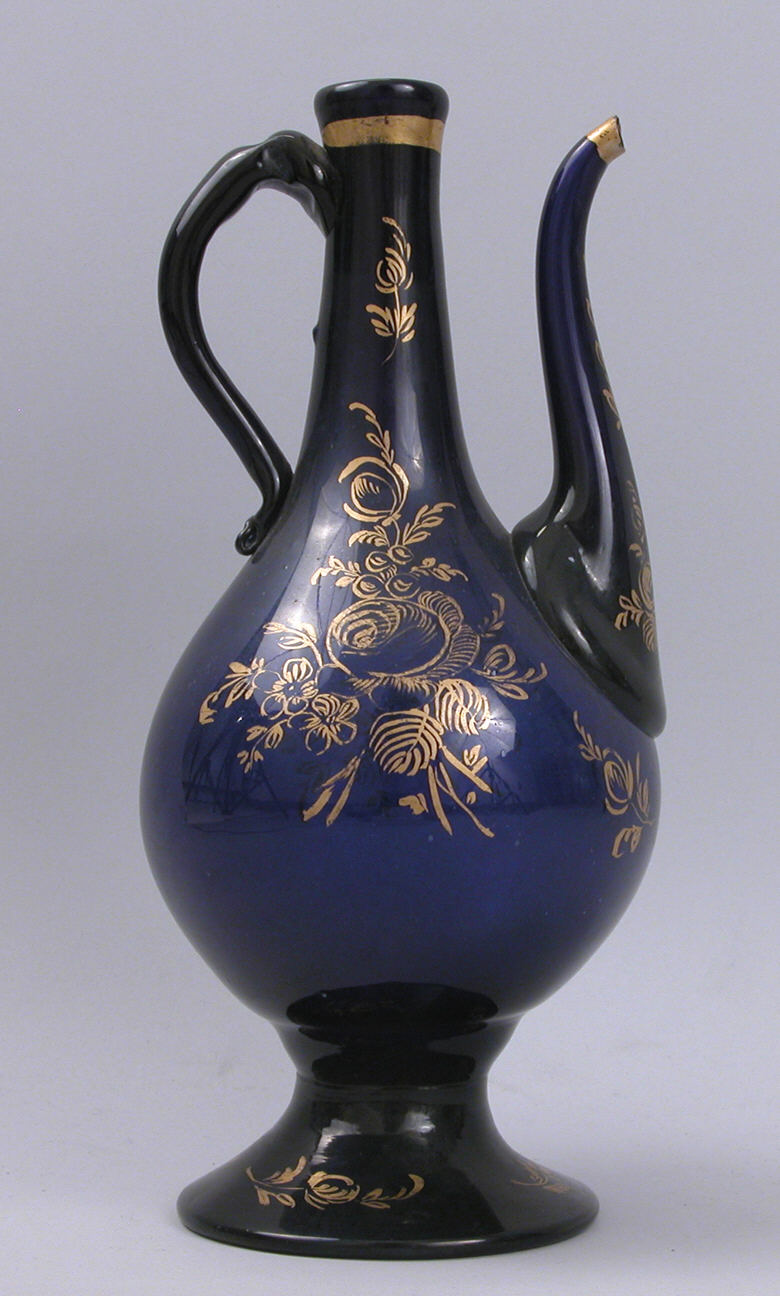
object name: ewer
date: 1701-1900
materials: glass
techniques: glassblowing, painting, tooling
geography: iran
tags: flowers,leaves